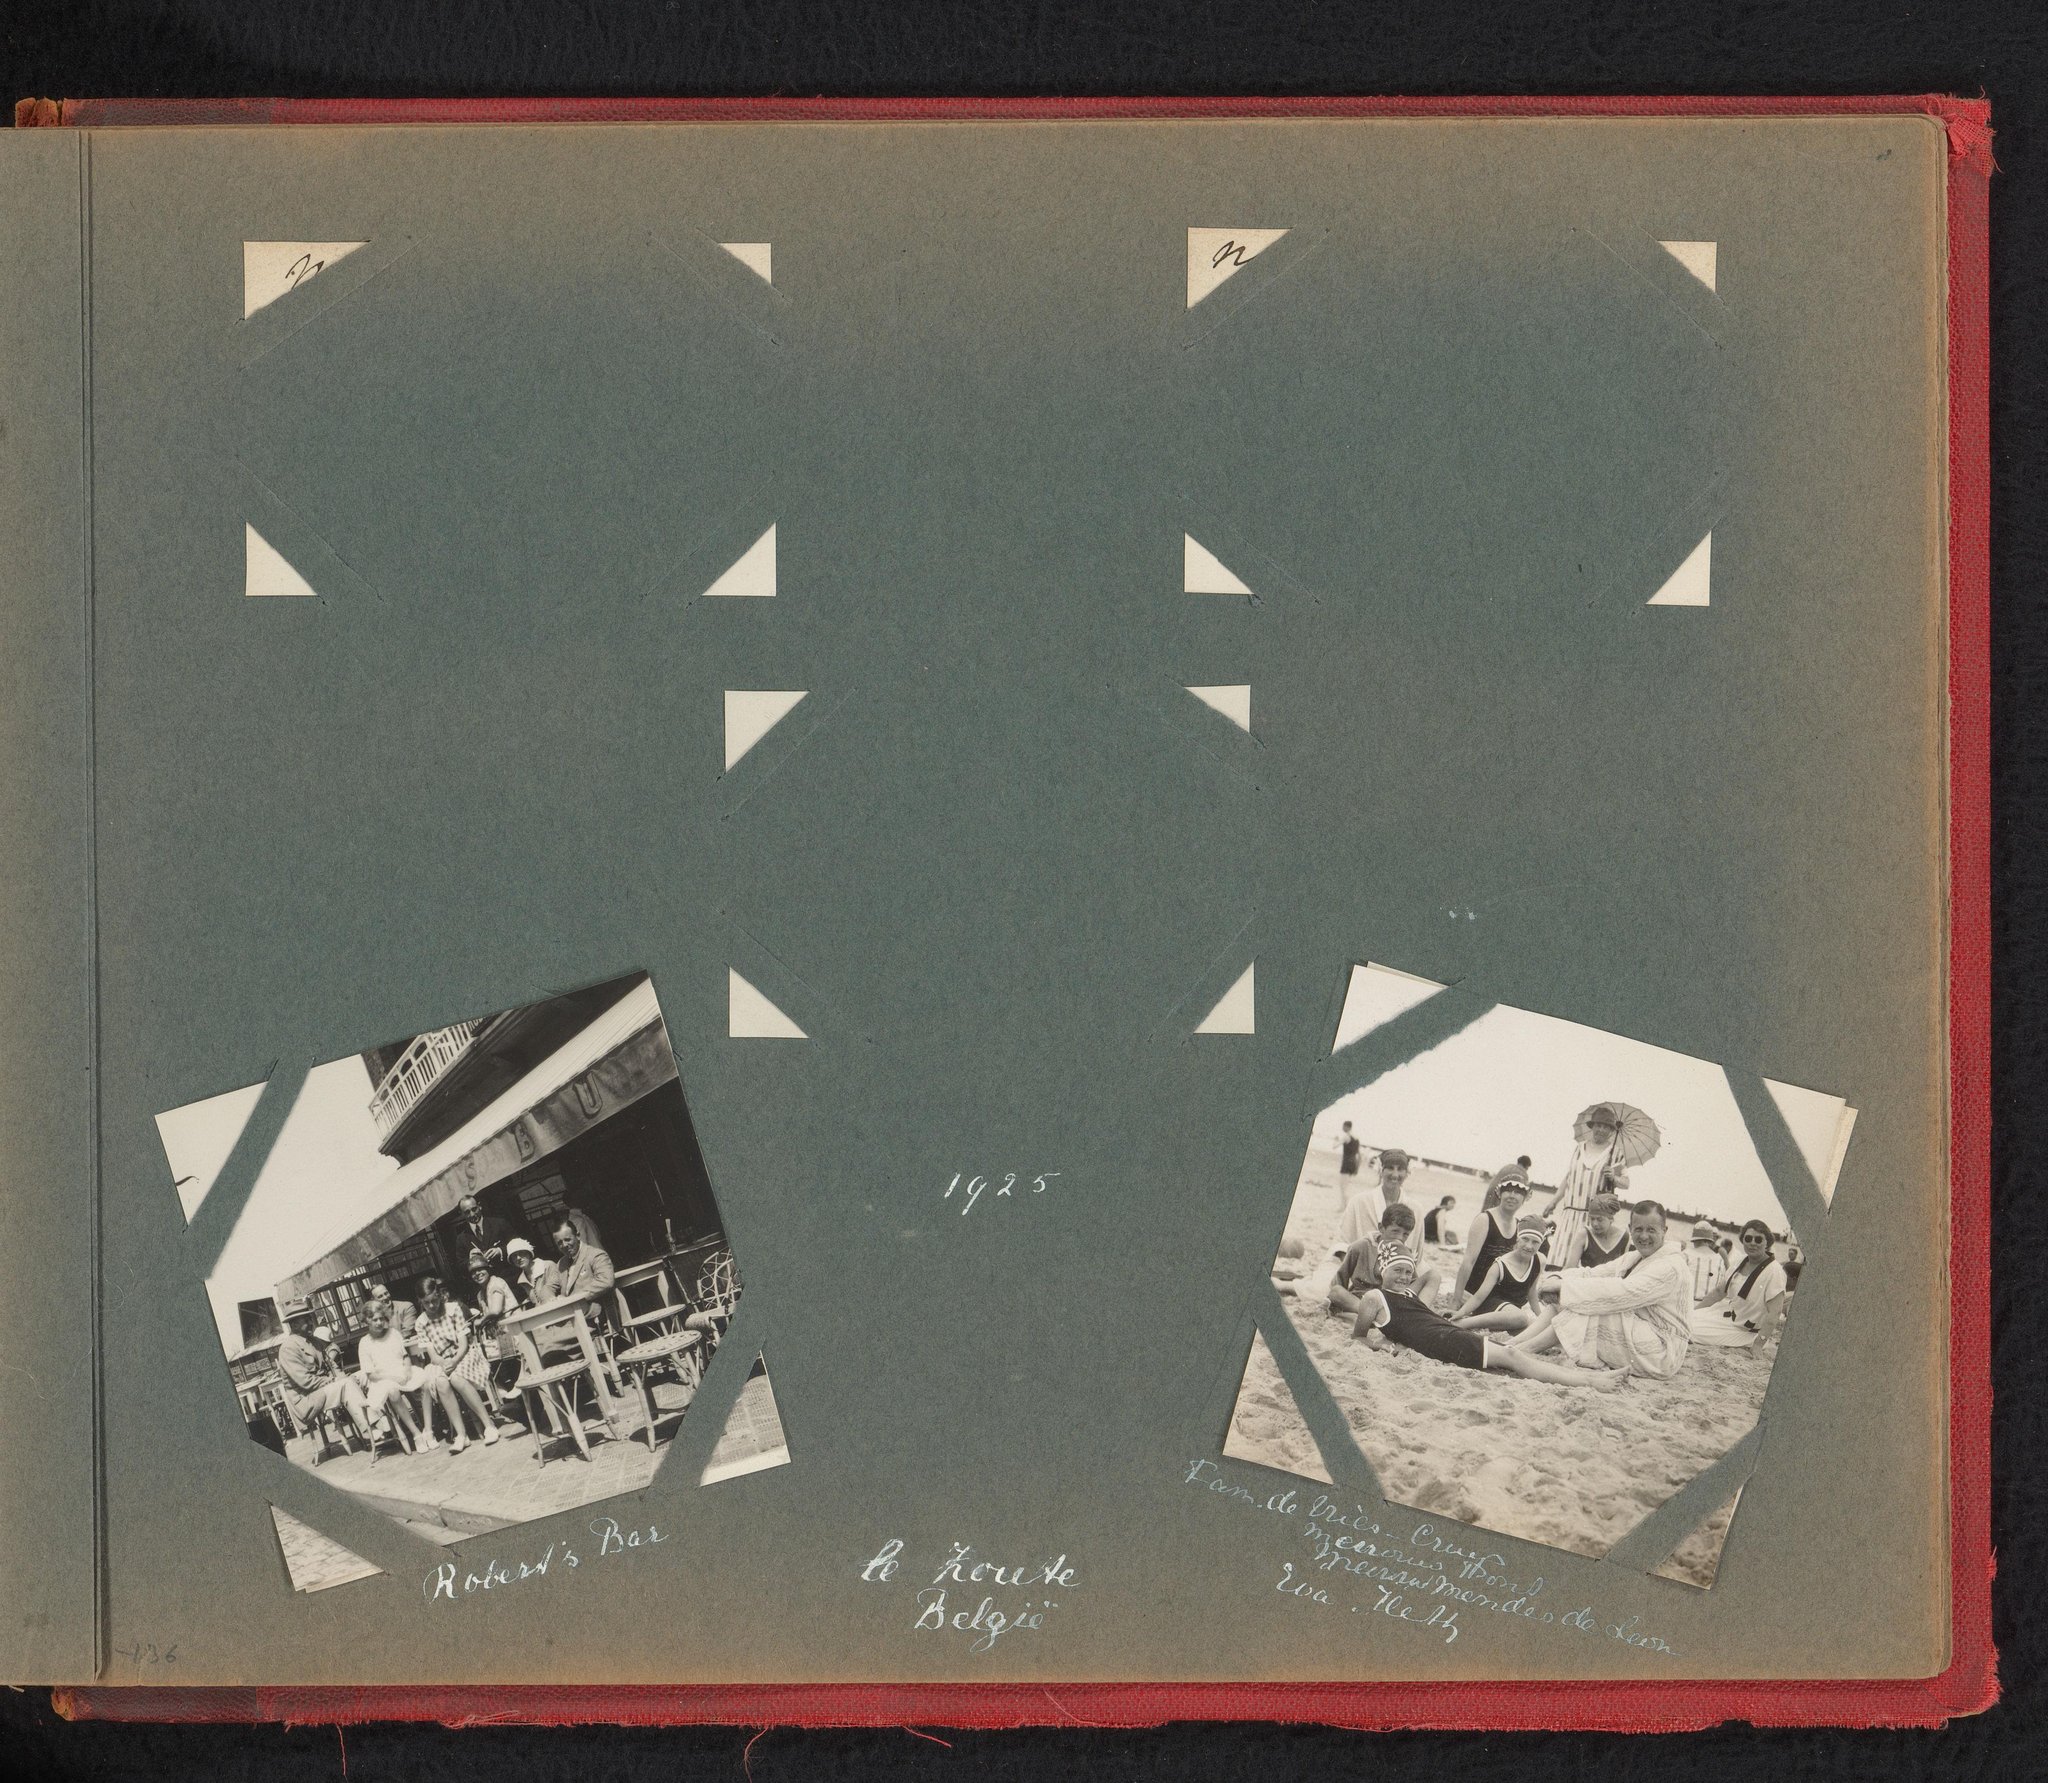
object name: photograph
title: Familie Boelen, met Eva en Hetty, en de families de Vries-Cruyp, Pont en Mendes de Leon, op het strand van het Zoute in Knokke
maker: charlotte alida boelen-matthes (lot)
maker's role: amateurfotograaf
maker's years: 1889-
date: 1925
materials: paper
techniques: gelatin silver print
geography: het zoute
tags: amsterdam, eva charlotte pennink-boelen, beach (as place of recreation)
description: Groot Plattenberg was eigendom van Jacob Theodorus (Co) Boelen.